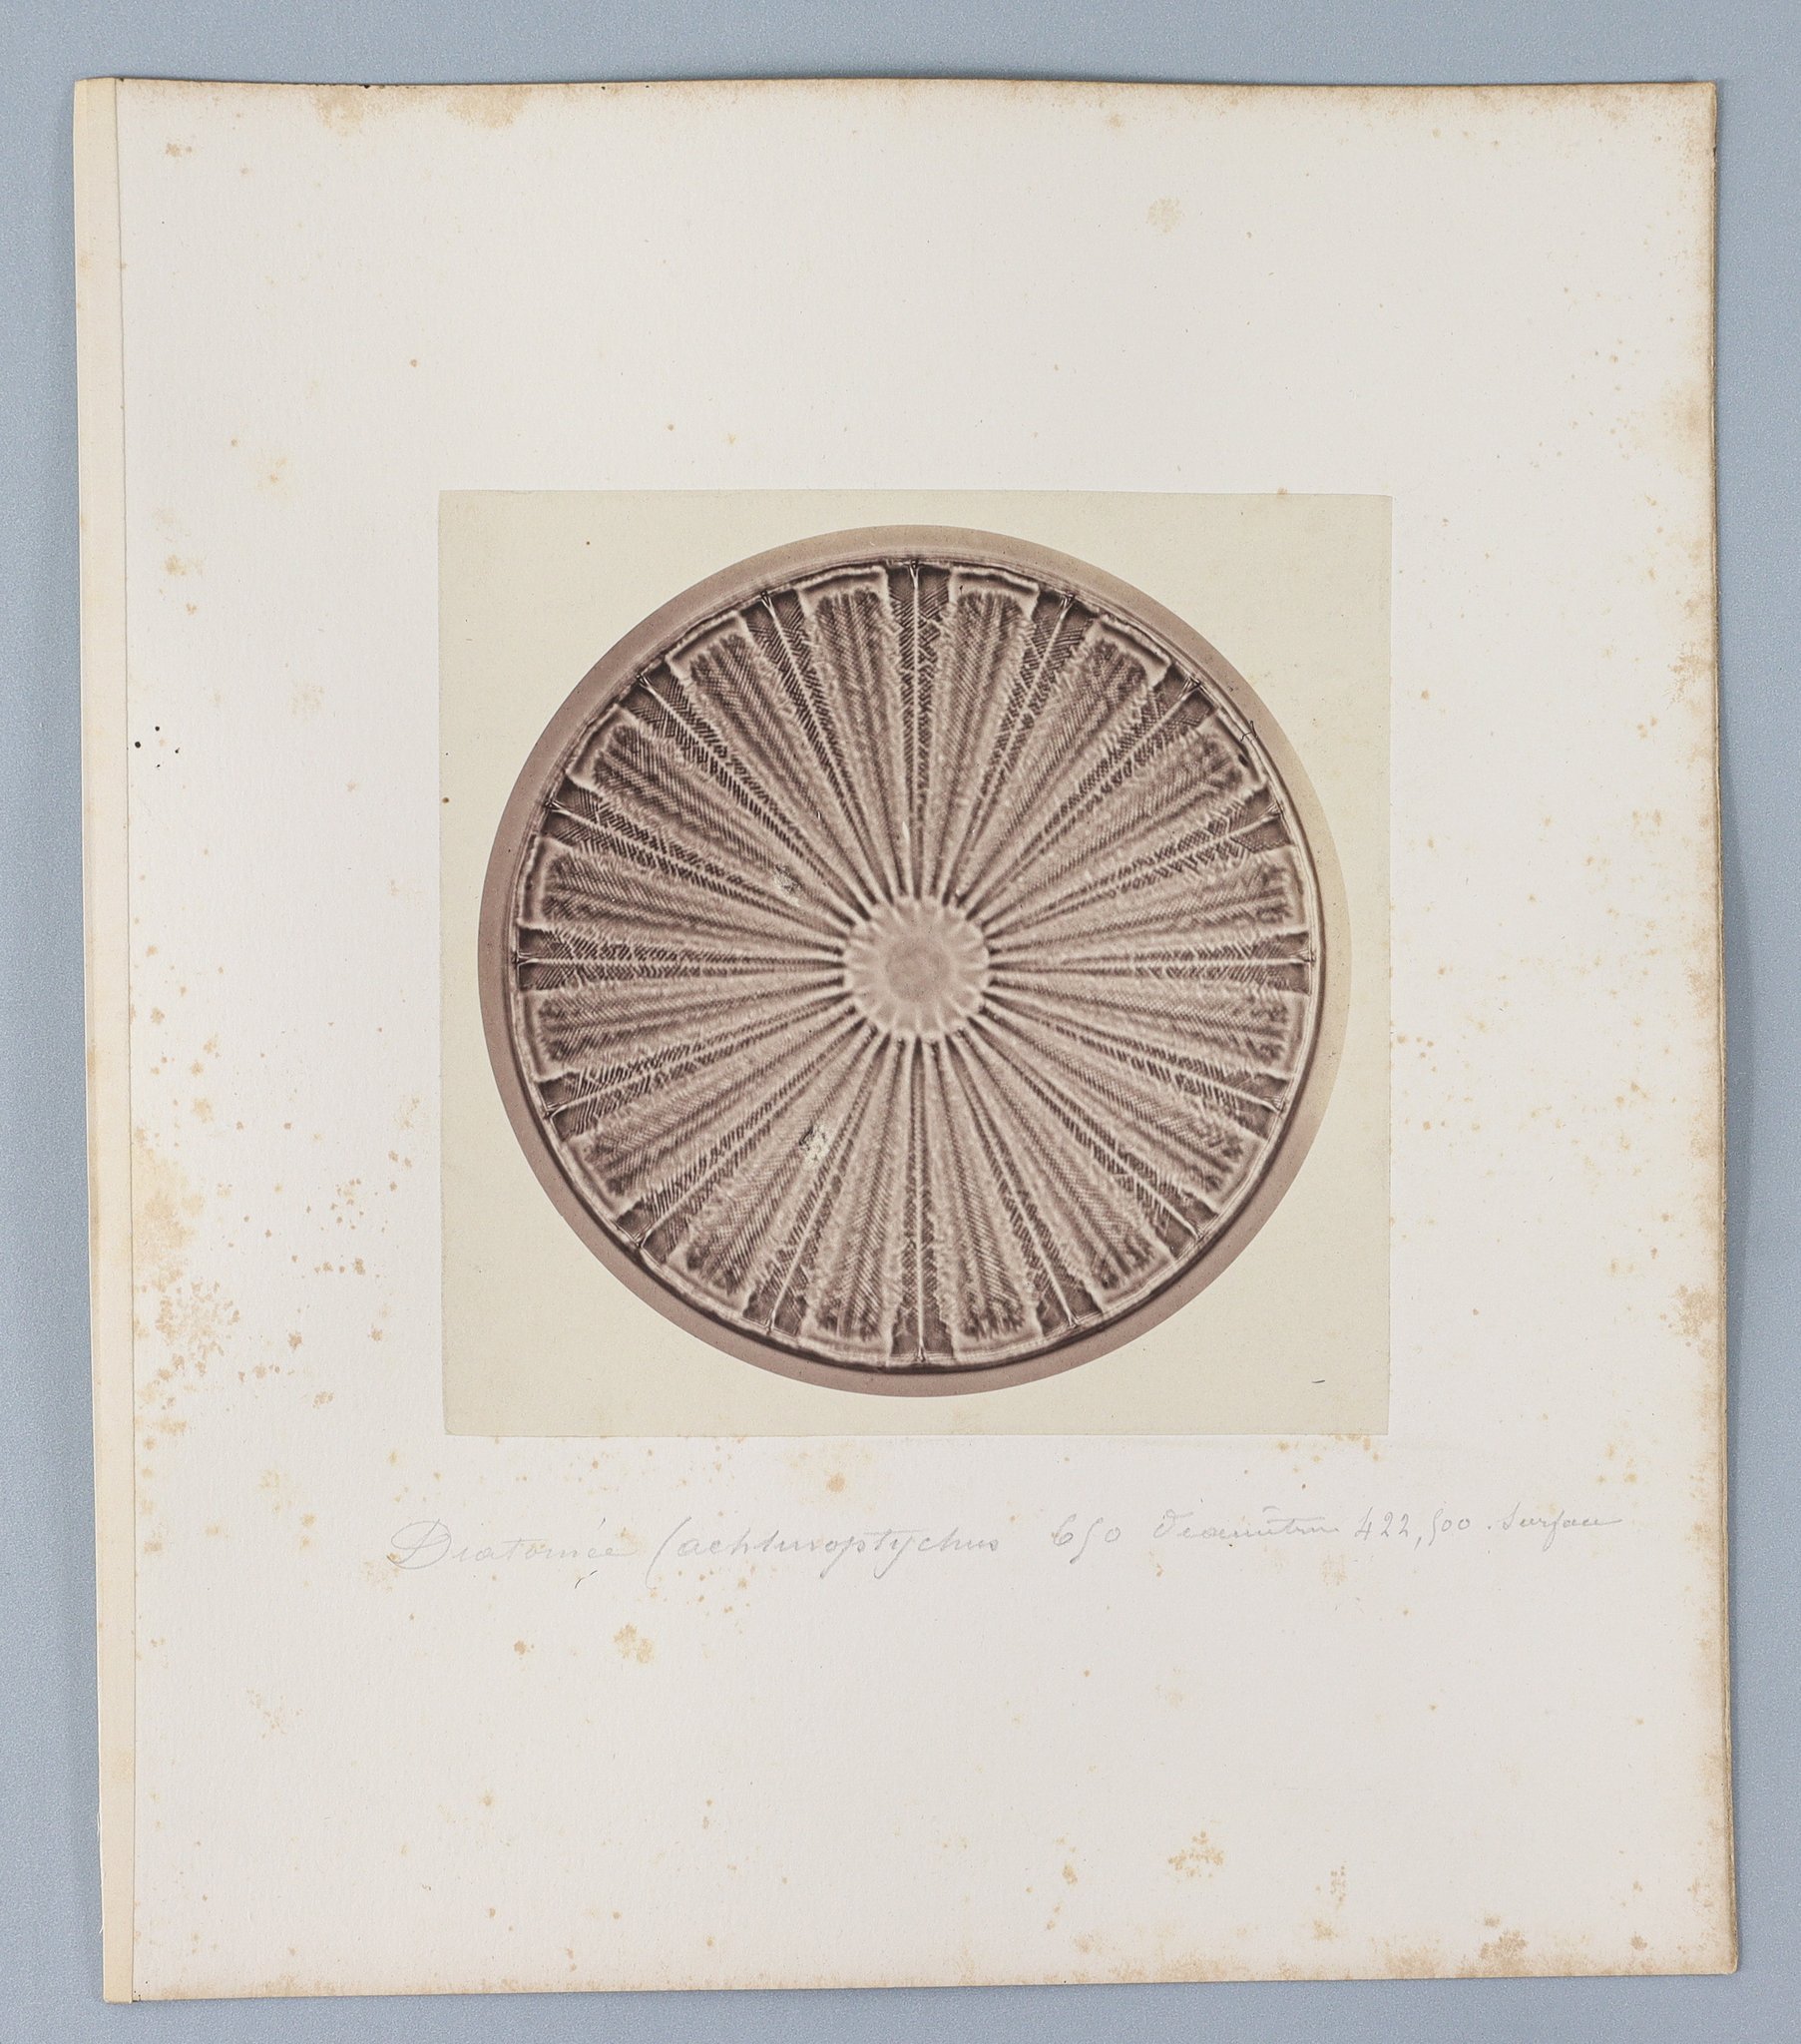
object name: photograph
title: [Untitled]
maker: auguste-adolphe bertsch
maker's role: artist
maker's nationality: french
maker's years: 1813-1871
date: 1853-1857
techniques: salted paper print